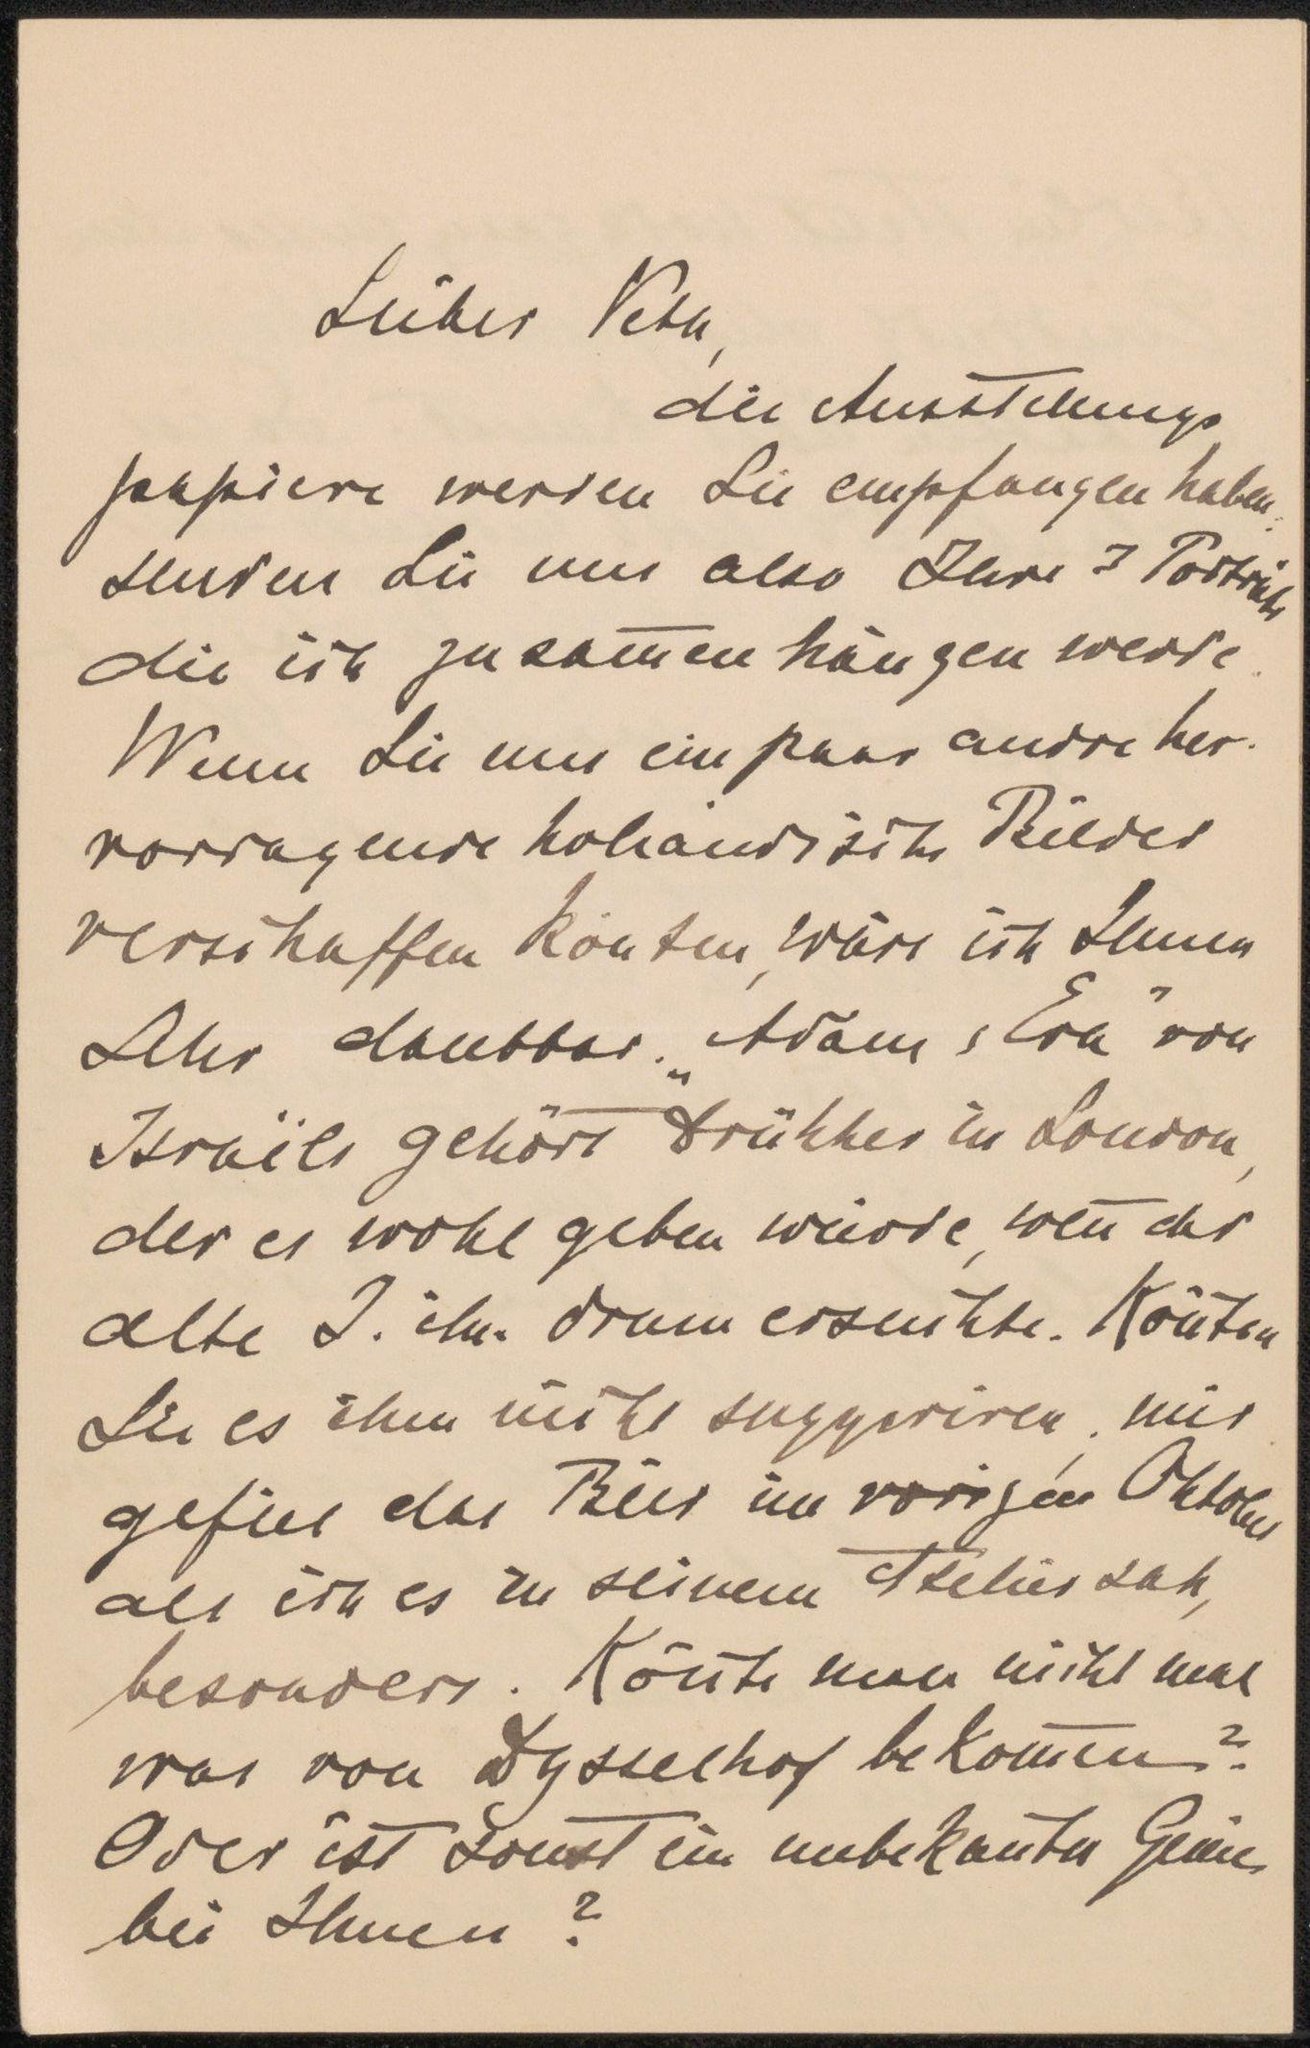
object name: letter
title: Brief aan Jan Veth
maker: max liebermann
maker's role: draughtsman, print maker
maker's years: 1847-1935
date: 1857-1925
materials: ink, paper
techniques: pen, writing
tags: jozef israëls, amsterdam, jan veth, print maker, draughtsman, designer, gerrit willem dijsselhof, paris, edouard manet, painter, james abbott mcneill whistler, rijksmuseum amsterdam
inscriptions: watermark, collector's mark: ‘RPK’